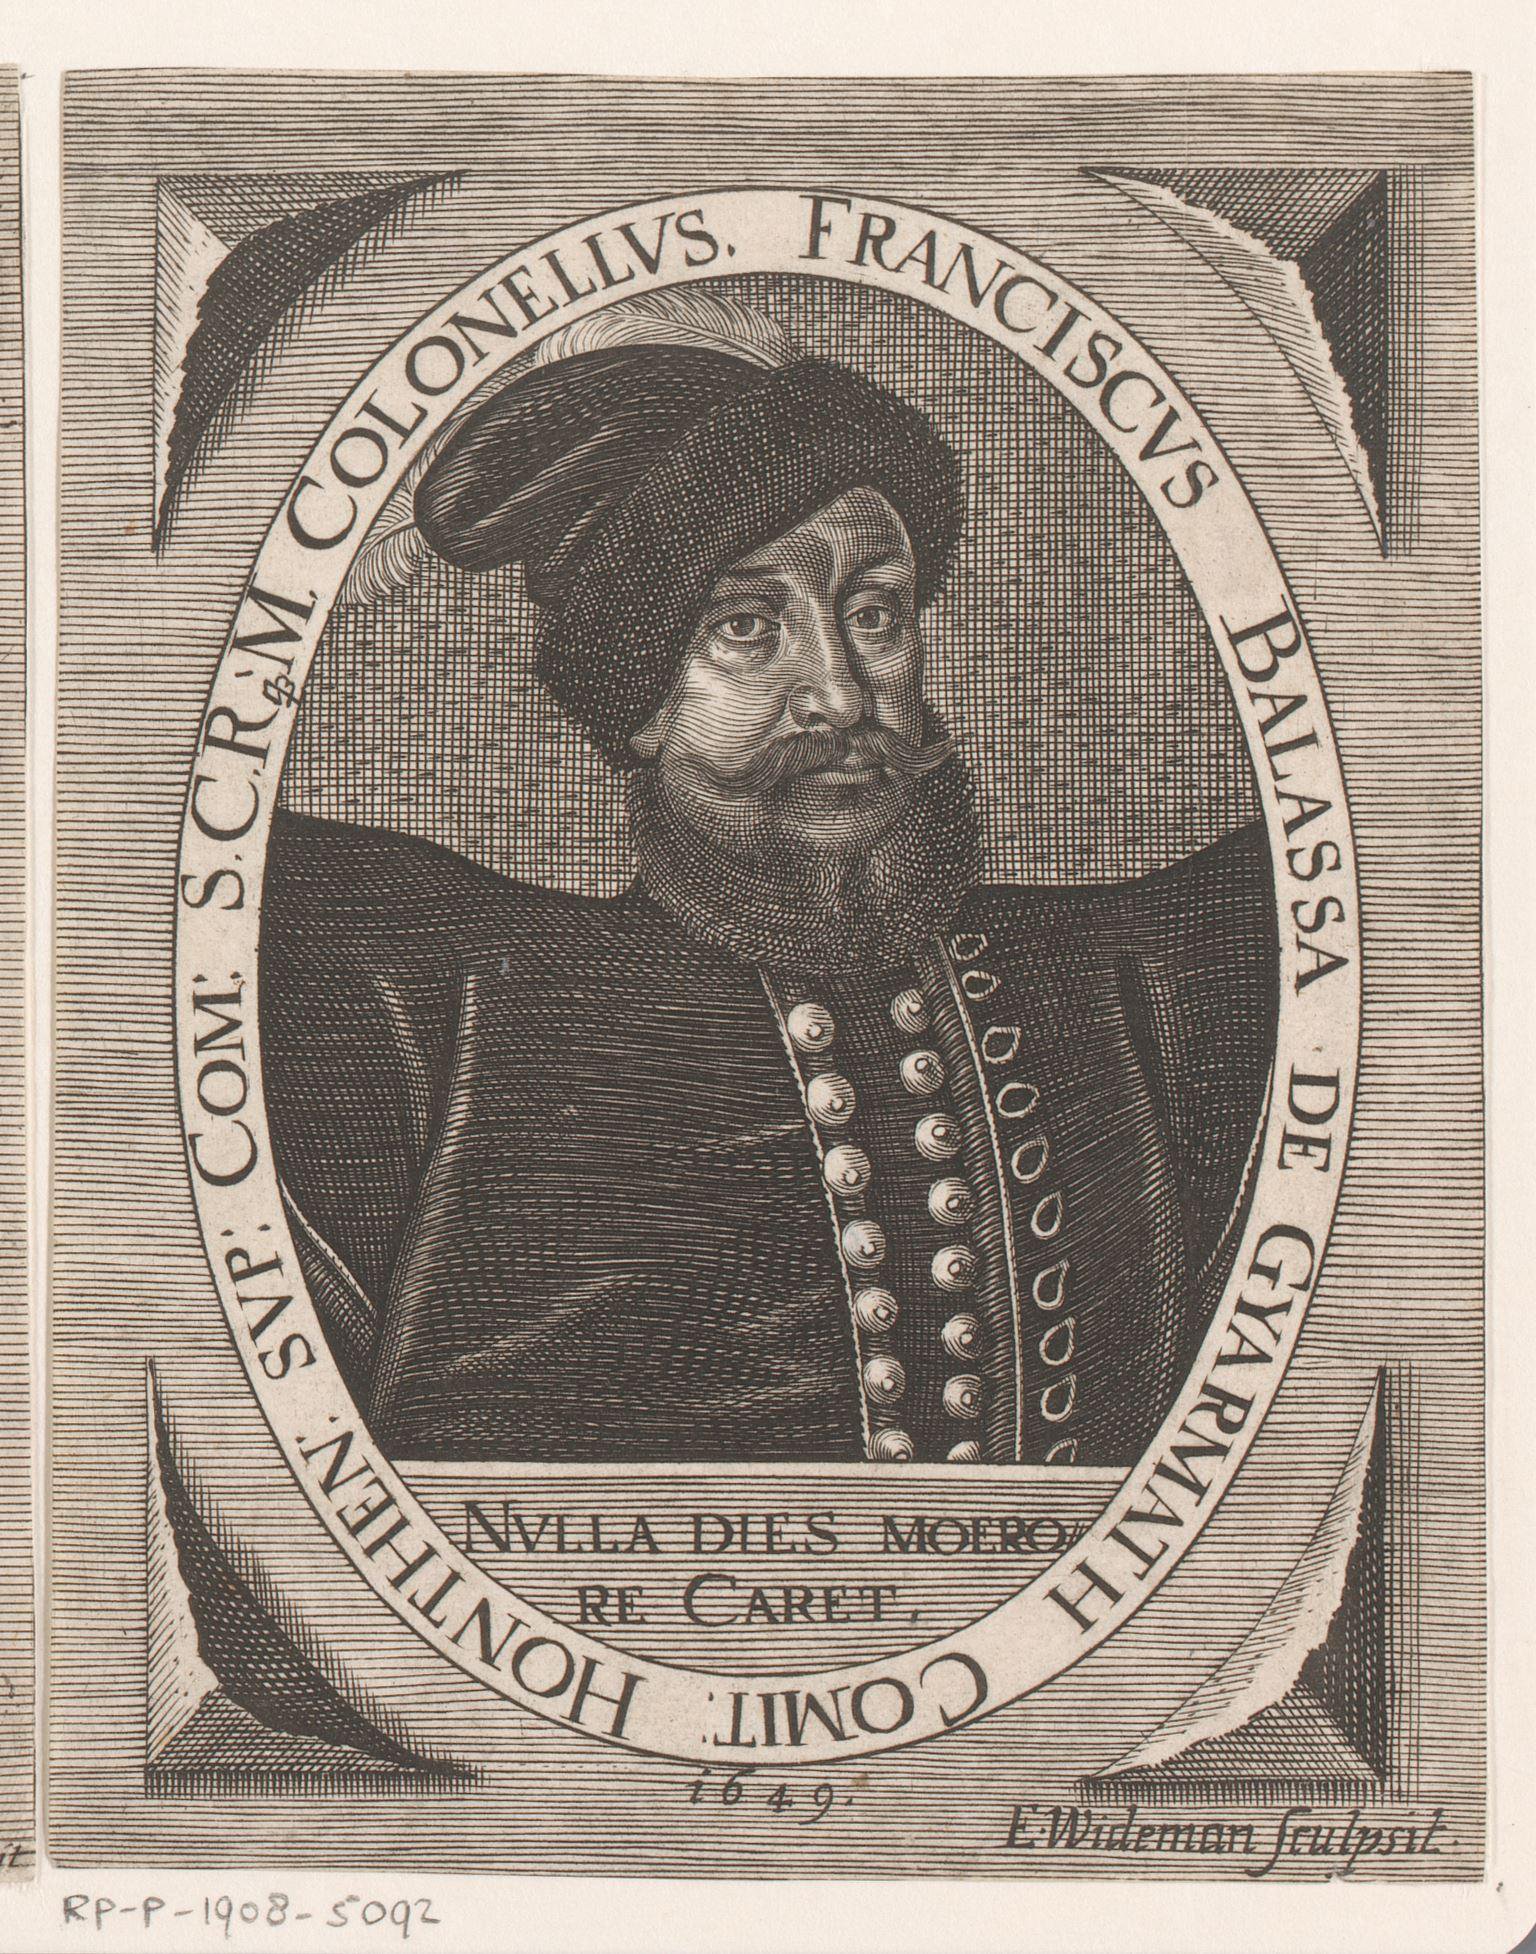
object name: print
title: Portret van Ferencz Balassa de Gyarmath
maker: elias widemann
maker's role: print maker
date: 1649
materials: paper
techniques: engraving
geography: vienna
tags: historical persons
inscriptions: collector's mark: Lugt 2228